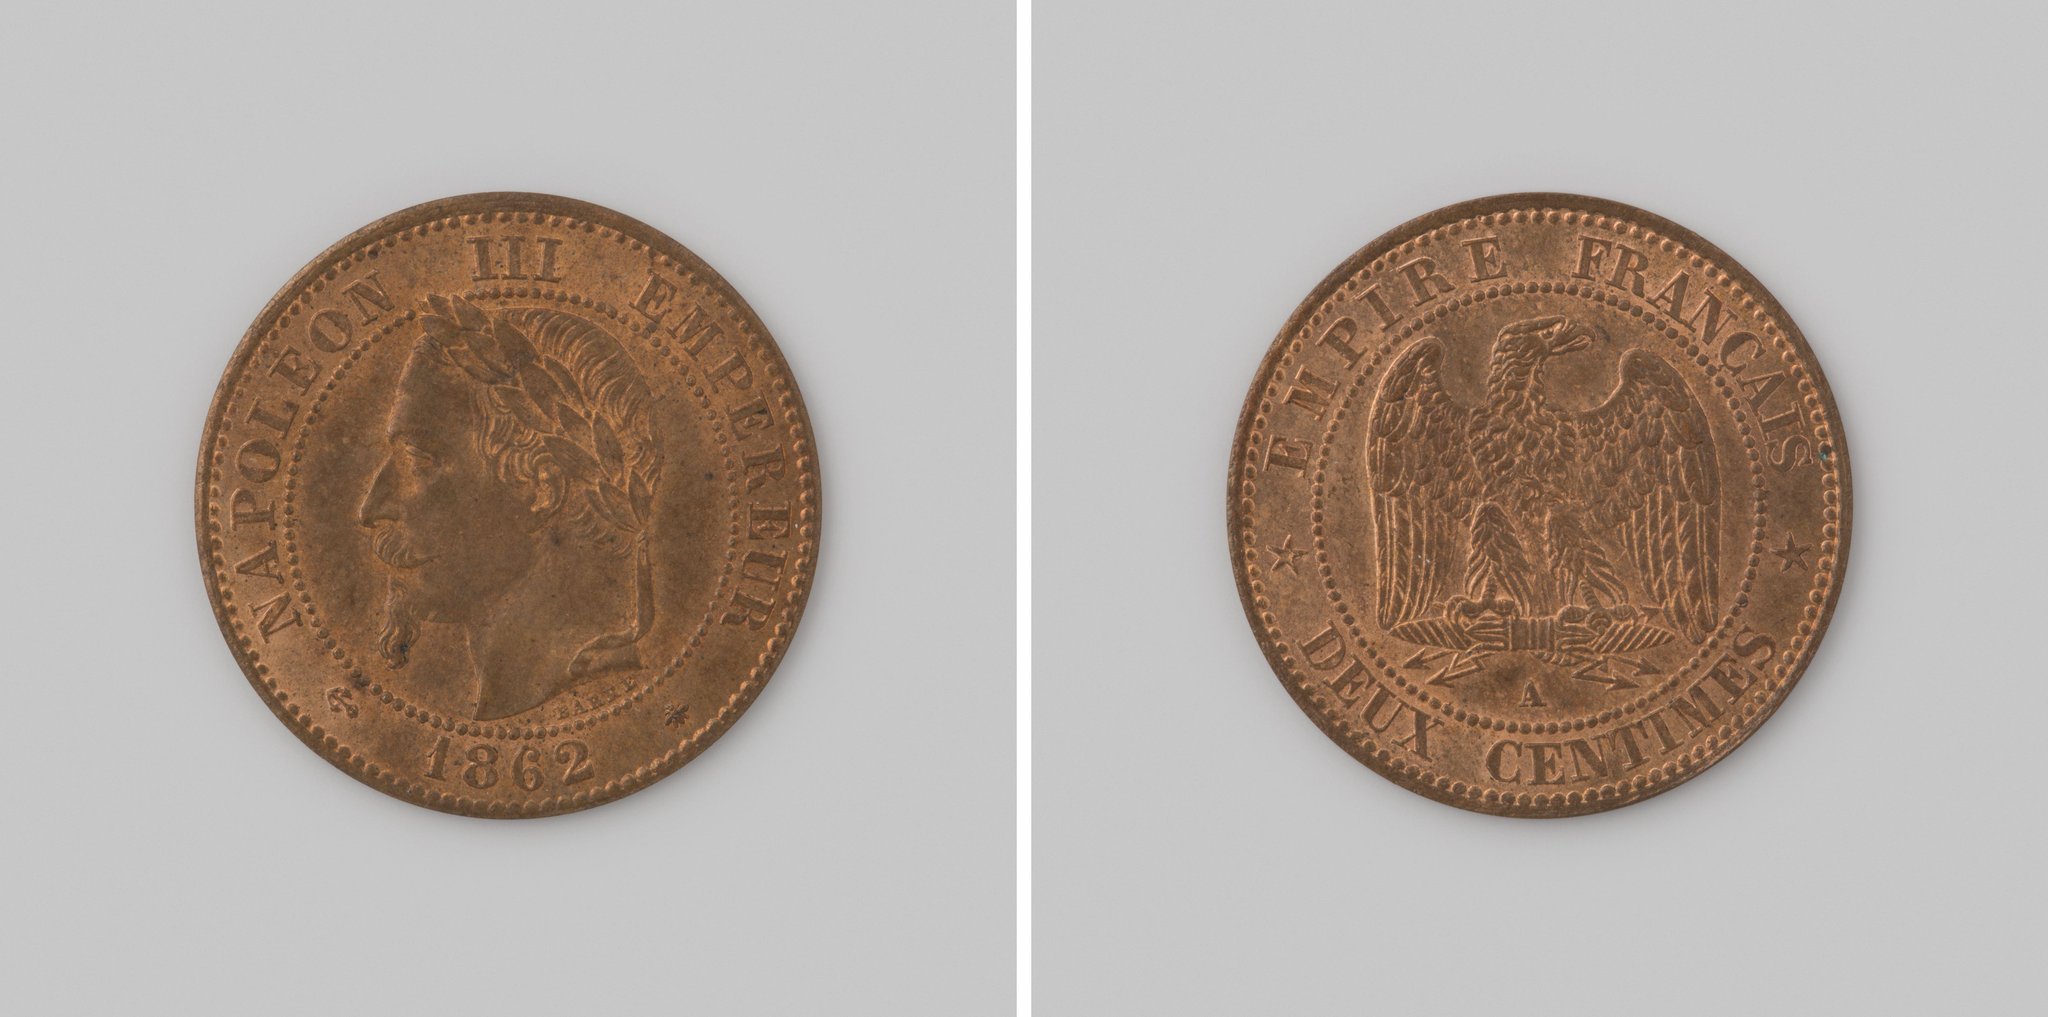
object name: coin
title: 2 centimes uit het keizerrijk Frankrijk van Napoleon III, 1862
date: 1862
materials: bronze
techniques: striking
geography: paris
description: Bronzen munt. Voorzijde: gelauwerd hoofd van de keizer naar links. Jaartal onderaan. Keerzijde: op bundel, waaruit bliksemschichten, staande, naar rechts kijkende adelaar met gespreide vleugels, waaronder de letter A [=Parijs]. Waarde-aanduiding onderaan in omschrift. Gladde rand.